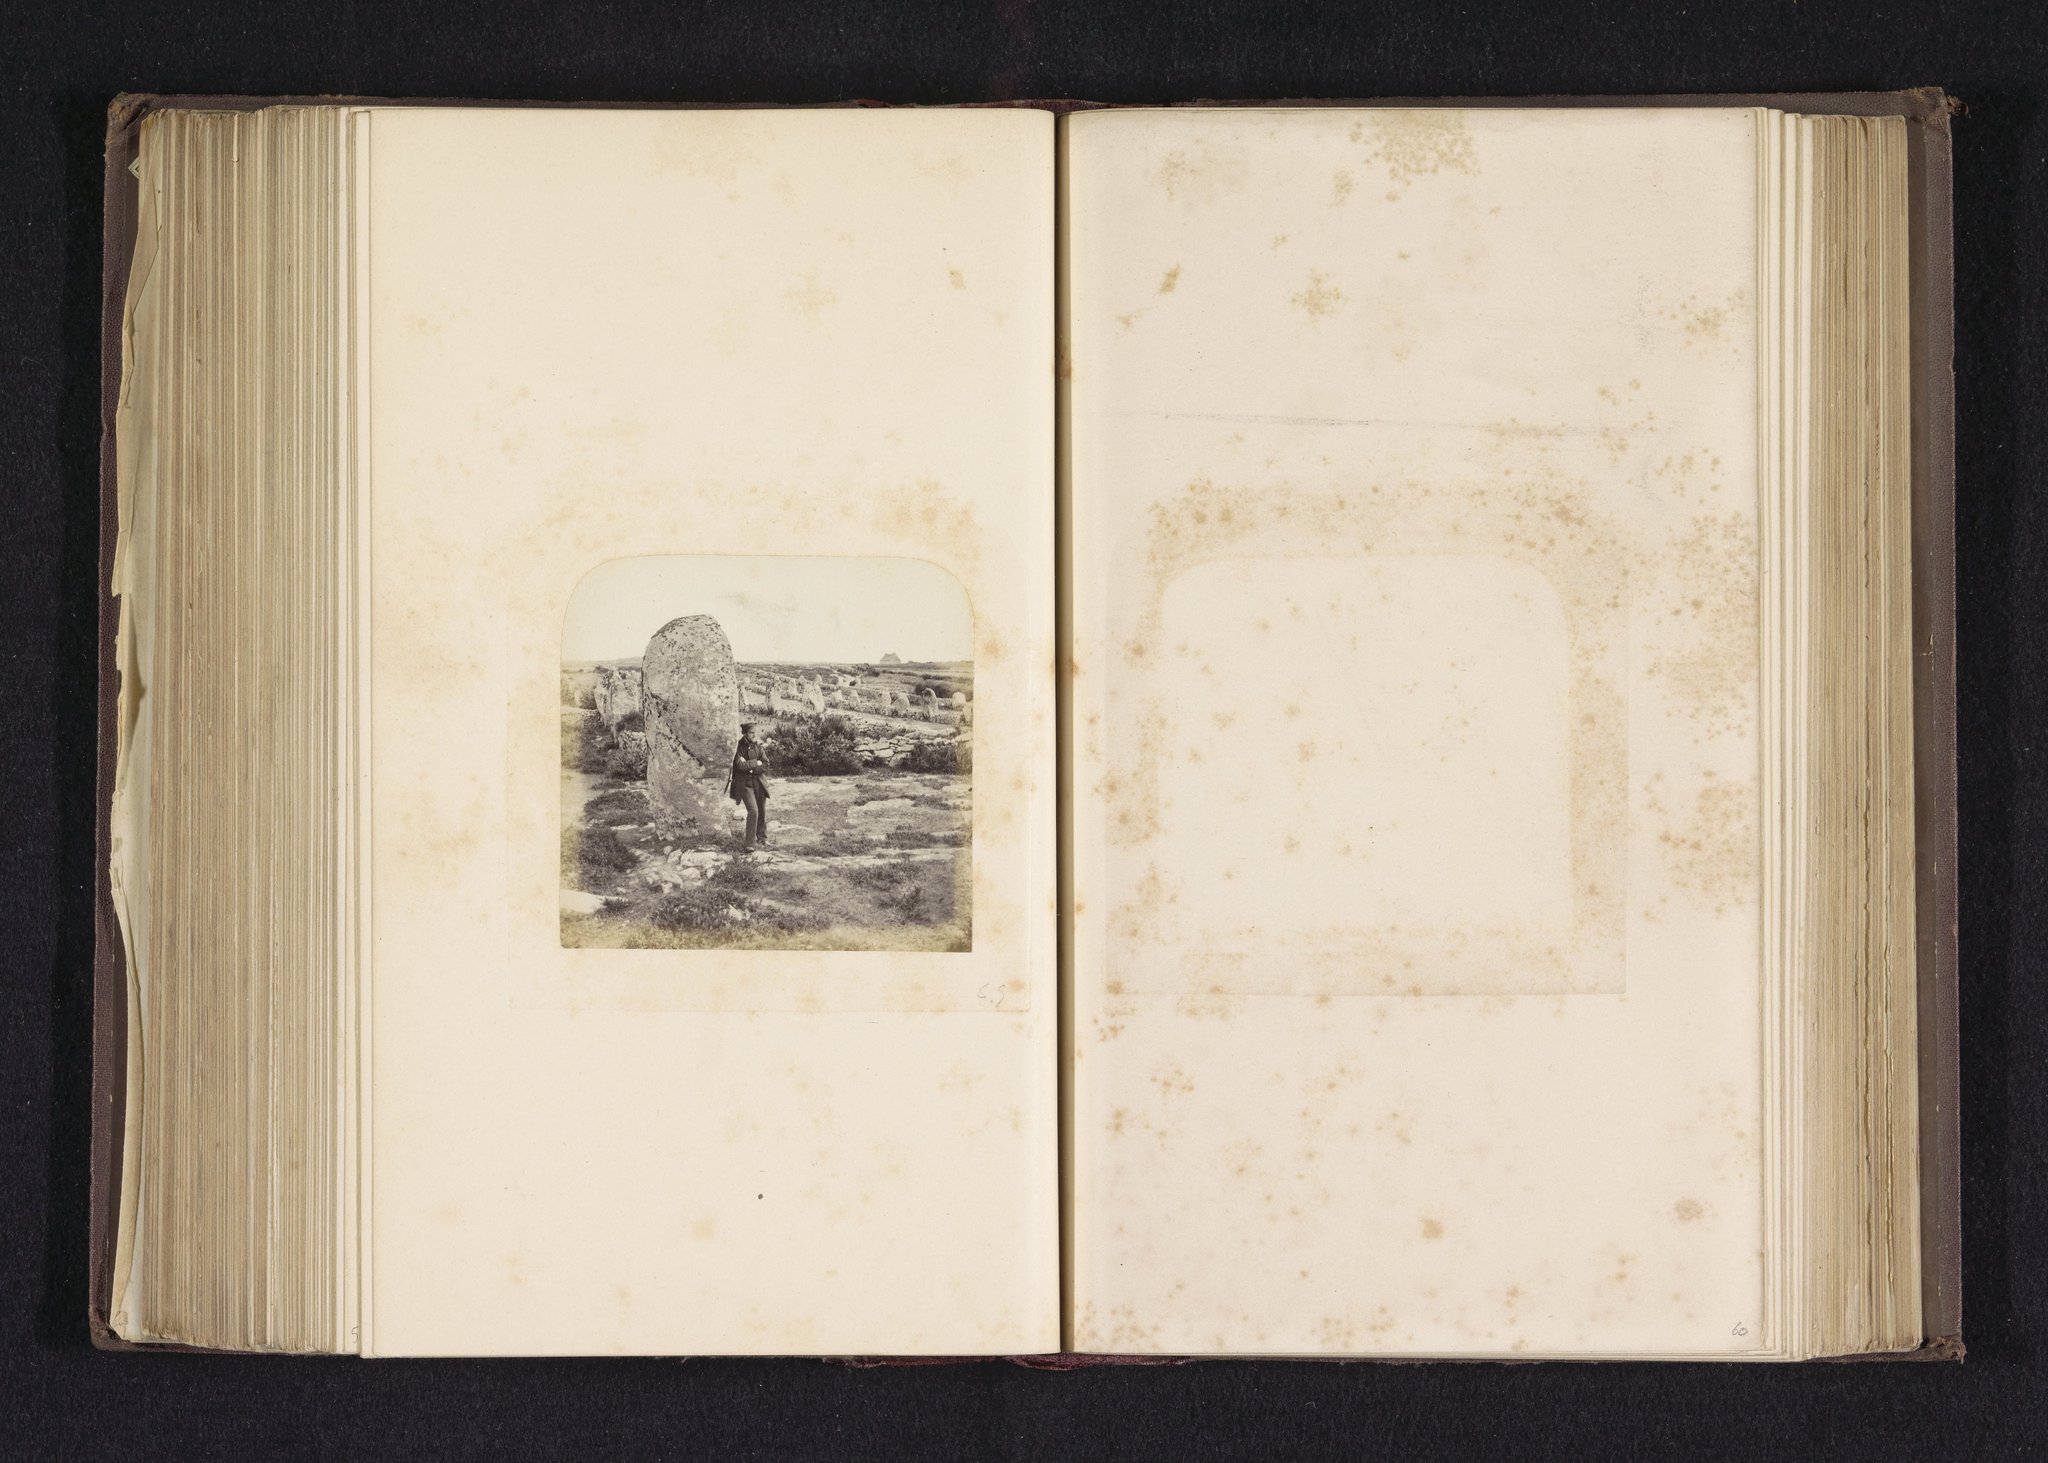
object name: page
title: Man staand tegen een menhir in een veld te Ménec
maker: taylor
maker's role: fotograaf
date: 1850-1859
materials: photographic support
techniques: albumen print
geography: carnac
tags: landscape with menhir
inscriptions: number: ‘59’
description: Foto op vijfde ongenummerde pagina na pagina 204.